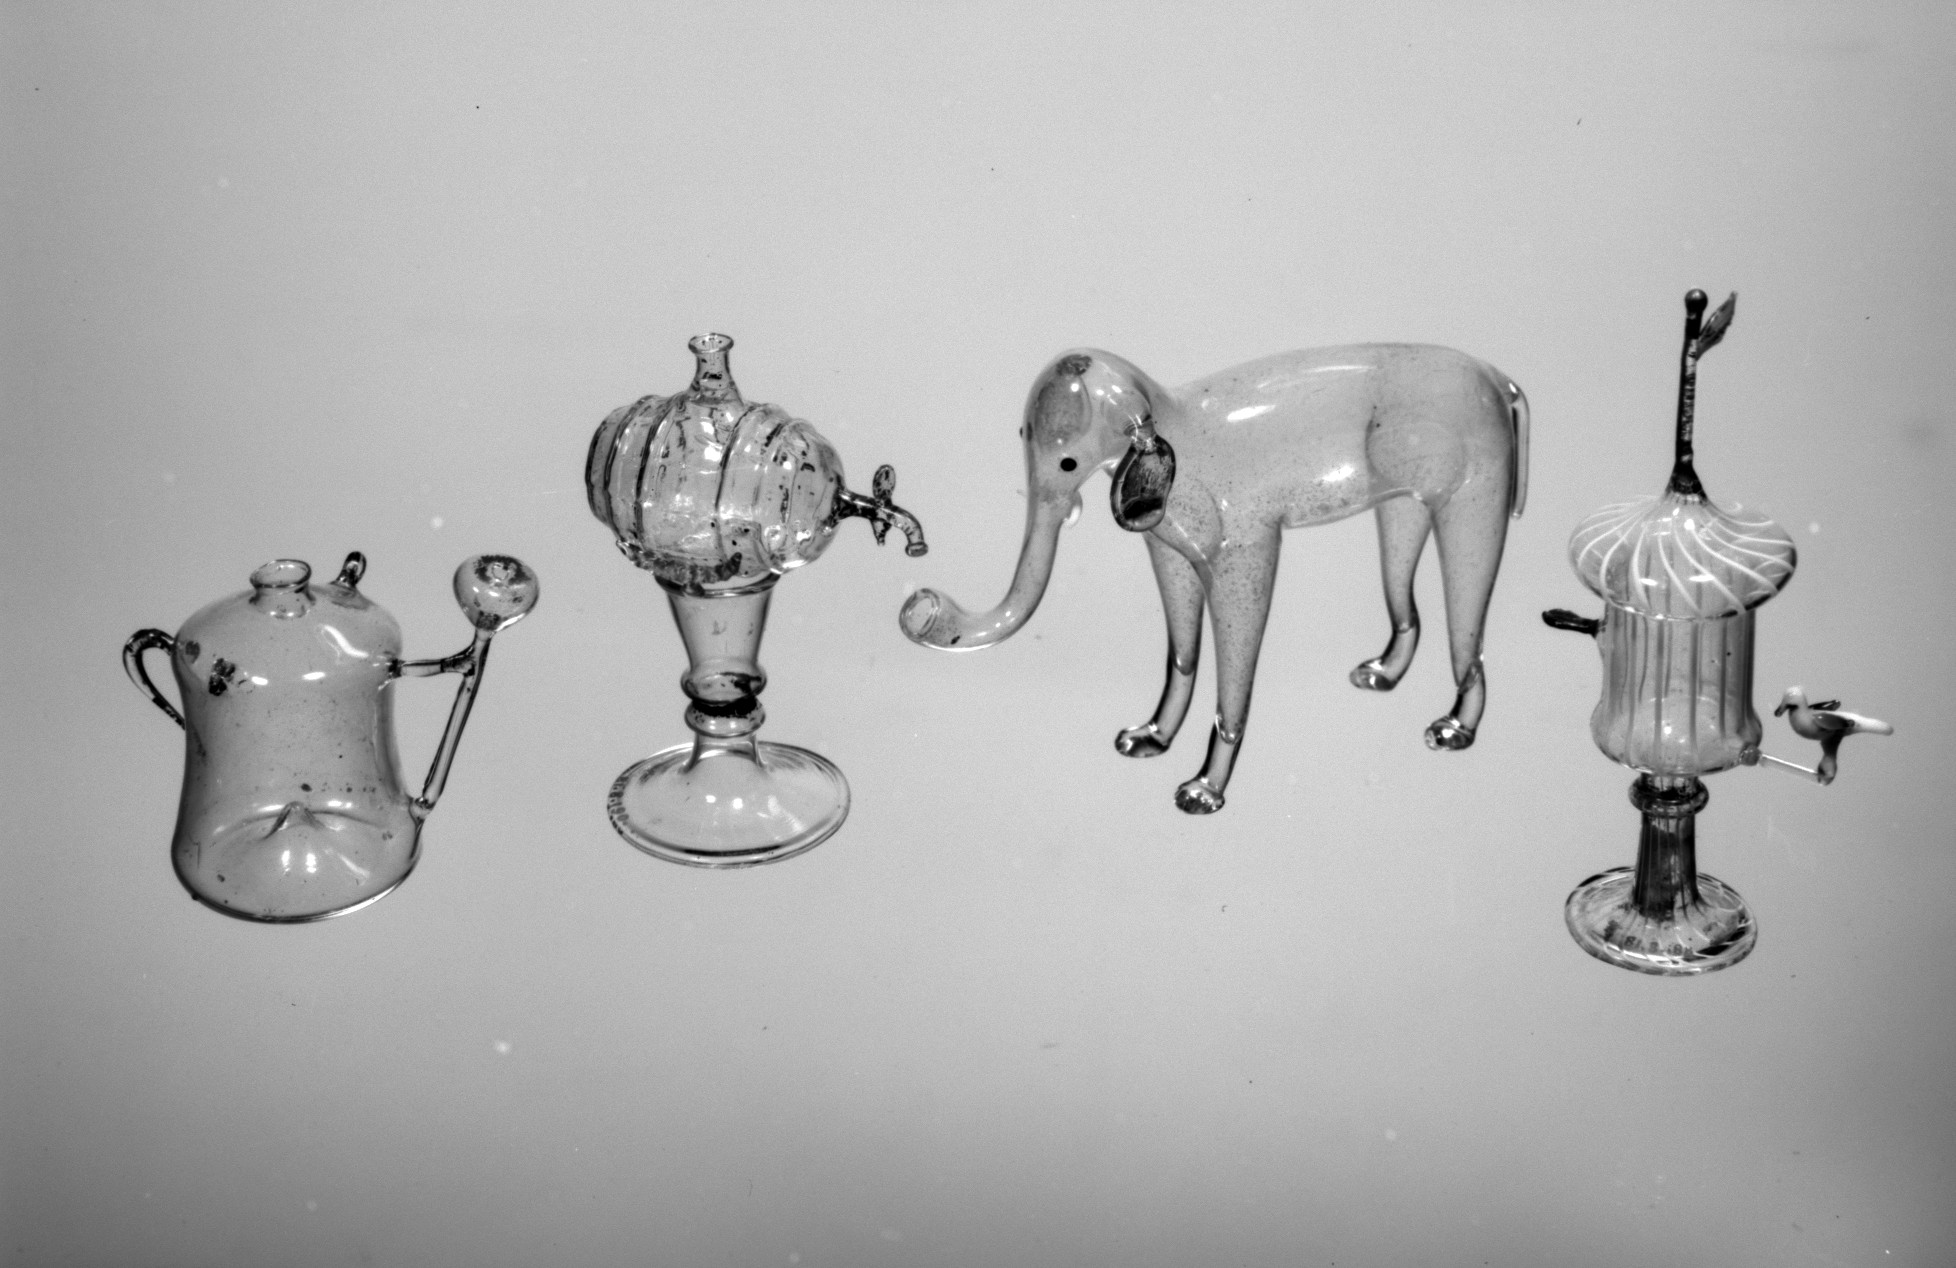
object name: birdcage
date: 1701-1900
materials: glass